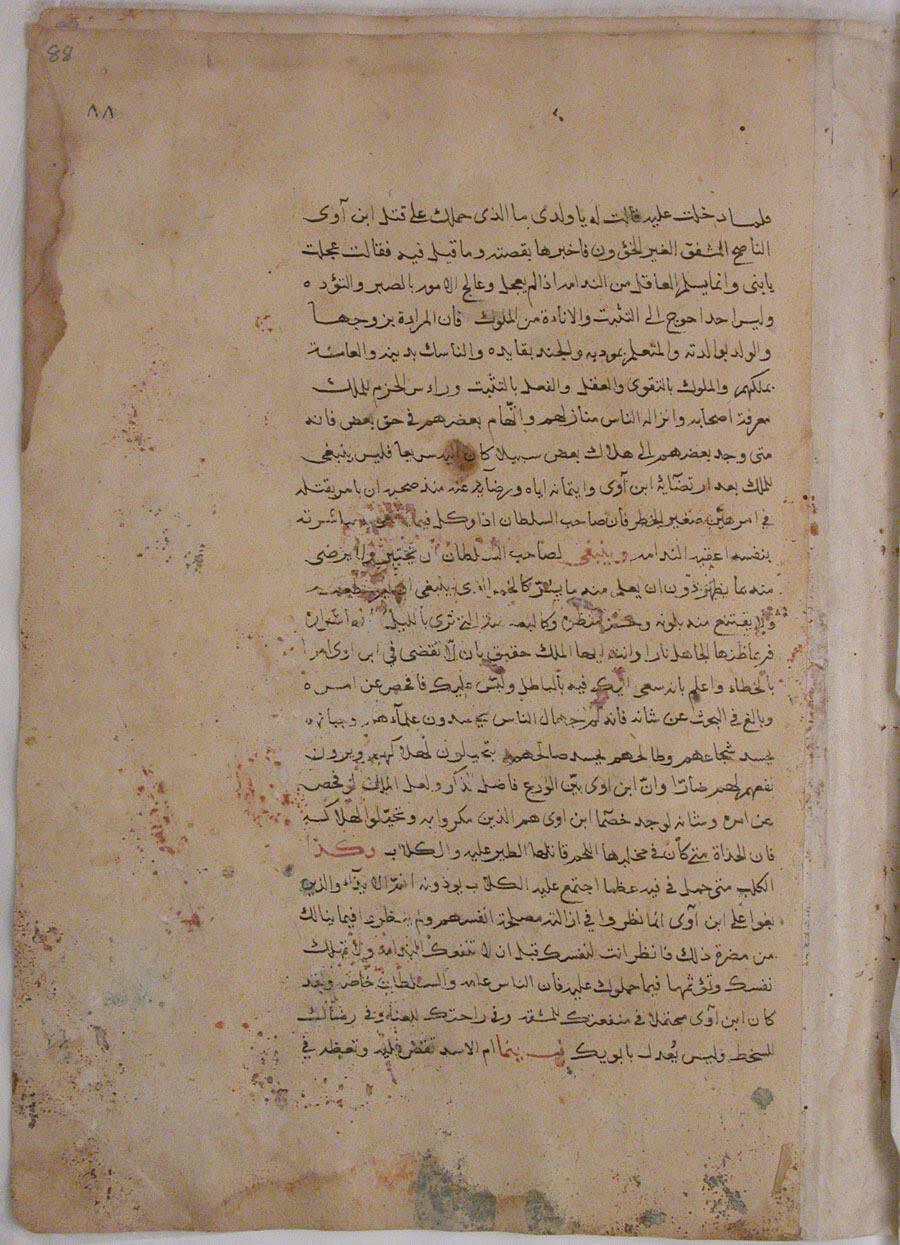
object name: folio from an illustrated manuscript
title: Page of Calligraphy from a Kalila wa Dimna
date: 1526-1550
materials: ink, paper, watercolor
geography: india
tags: arabic,calligraphy